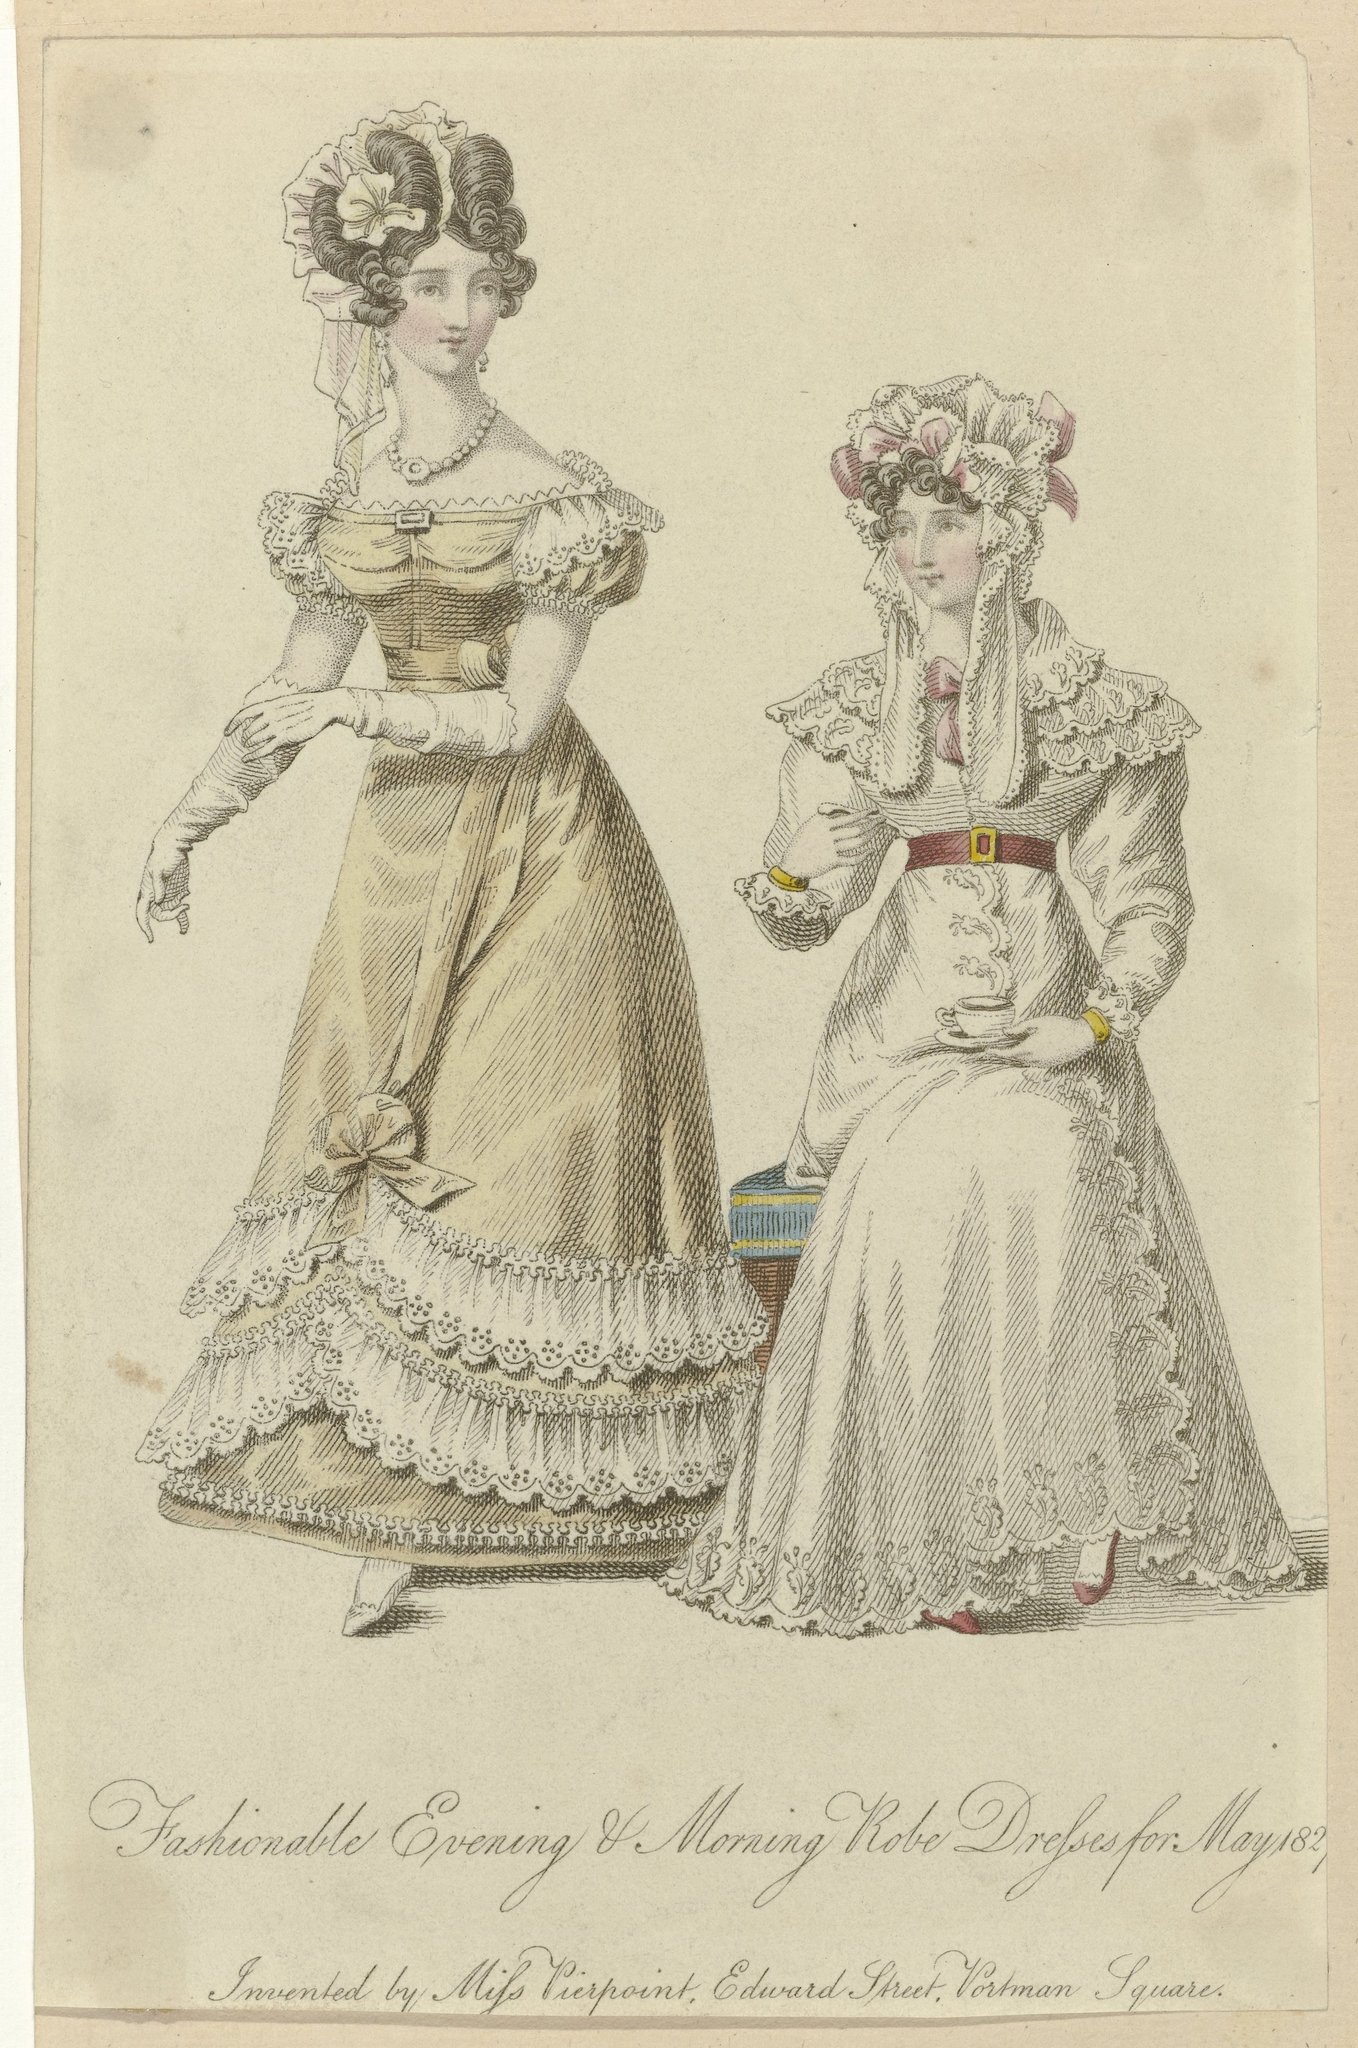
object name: fashion print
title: Fashionable Evening & Morning Robe Dresses for May 1827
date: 1827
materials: paper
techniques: etching, hand coloring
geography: london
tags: ear-rings (+ women's clothes), dress, gown: evening dress (+ women's clothes), gloves, mittens (long gloves) (+ women's clothes), dress, gown: morning dress (+ women's clothes), styles of hairdress - aa - ~ women, head-gear: cap (+ women's clothes), neck-gear: collar (+ women's clothes), fashion plates, shoes, sandals (+ women's clothes), necklace (+ women's clothes), cup and saucer, belt, girdle, waistband (+ women's clothes)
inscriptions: caption: ‘Fashionable Evening & Morning Robe Dresses for May 1827’, address: ‘Invented by Miss Pierpoint. Edward Street, Portman Square.’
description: Modieuze avondjapon en ochtendjapon voor mei 1827 ontworpen door Miss Pierpoint . Accessoires: oorbellen, collier, broche, lange handschoenen met gekartelde zoom. Muts met slippen, ceintuur met gesp, armbanden om beide polsen.